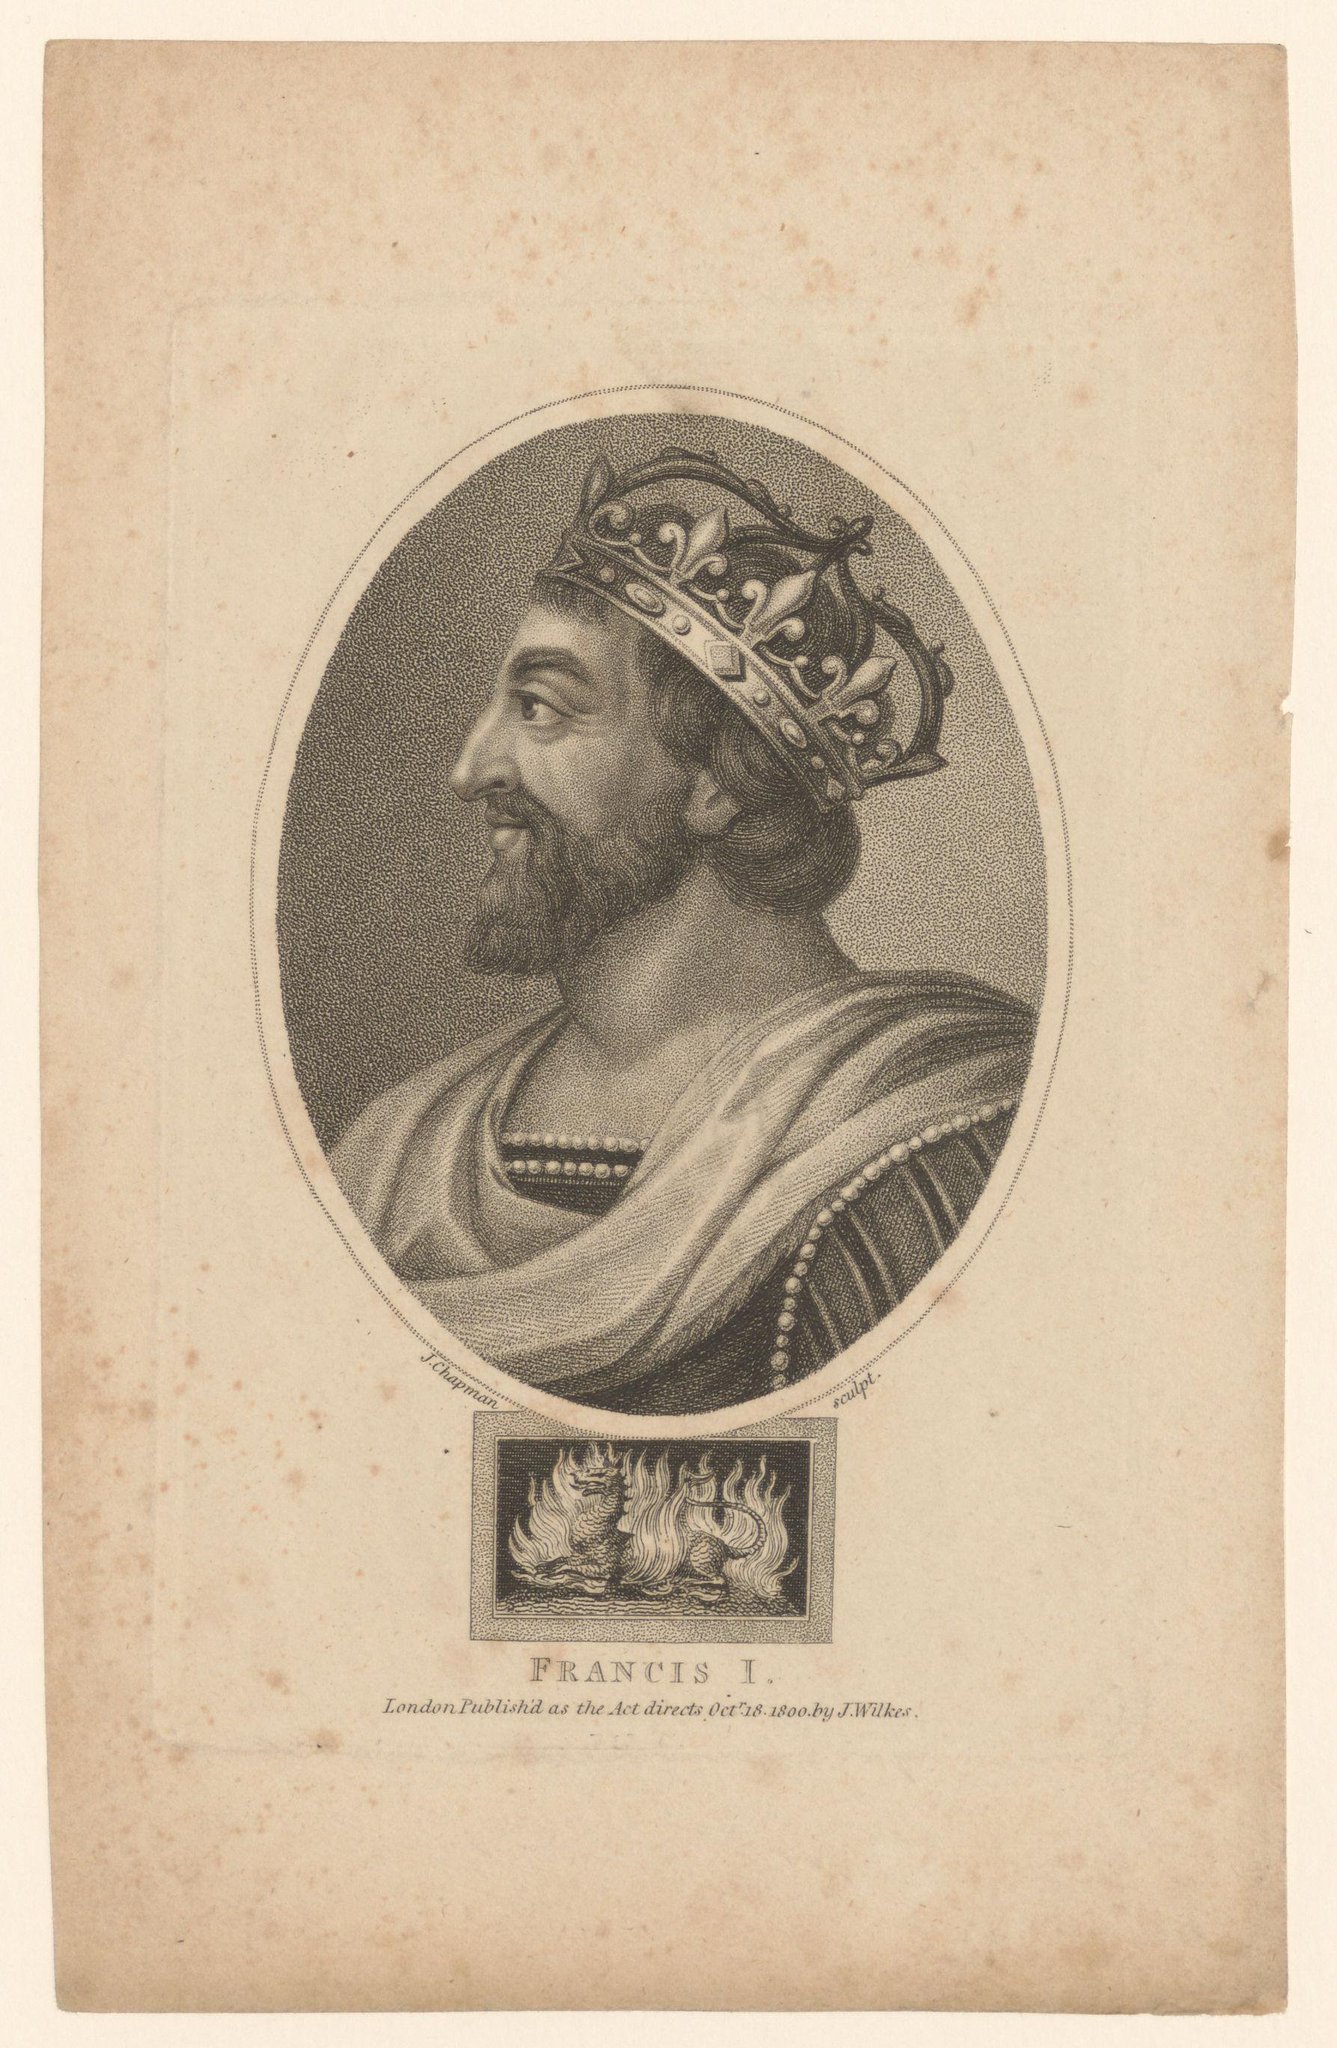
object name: print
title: Portret van Frans I, koning van Frankrijk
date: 1800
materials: paper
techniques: stippling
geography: london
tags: frans i van valois-angoulême (koning van frankrijk), historical persons, dragon, king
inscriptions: collector's mark: Lugt 2228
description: Deze prent maakt mogelijk deel uit van een reeks met portretten van koningen.